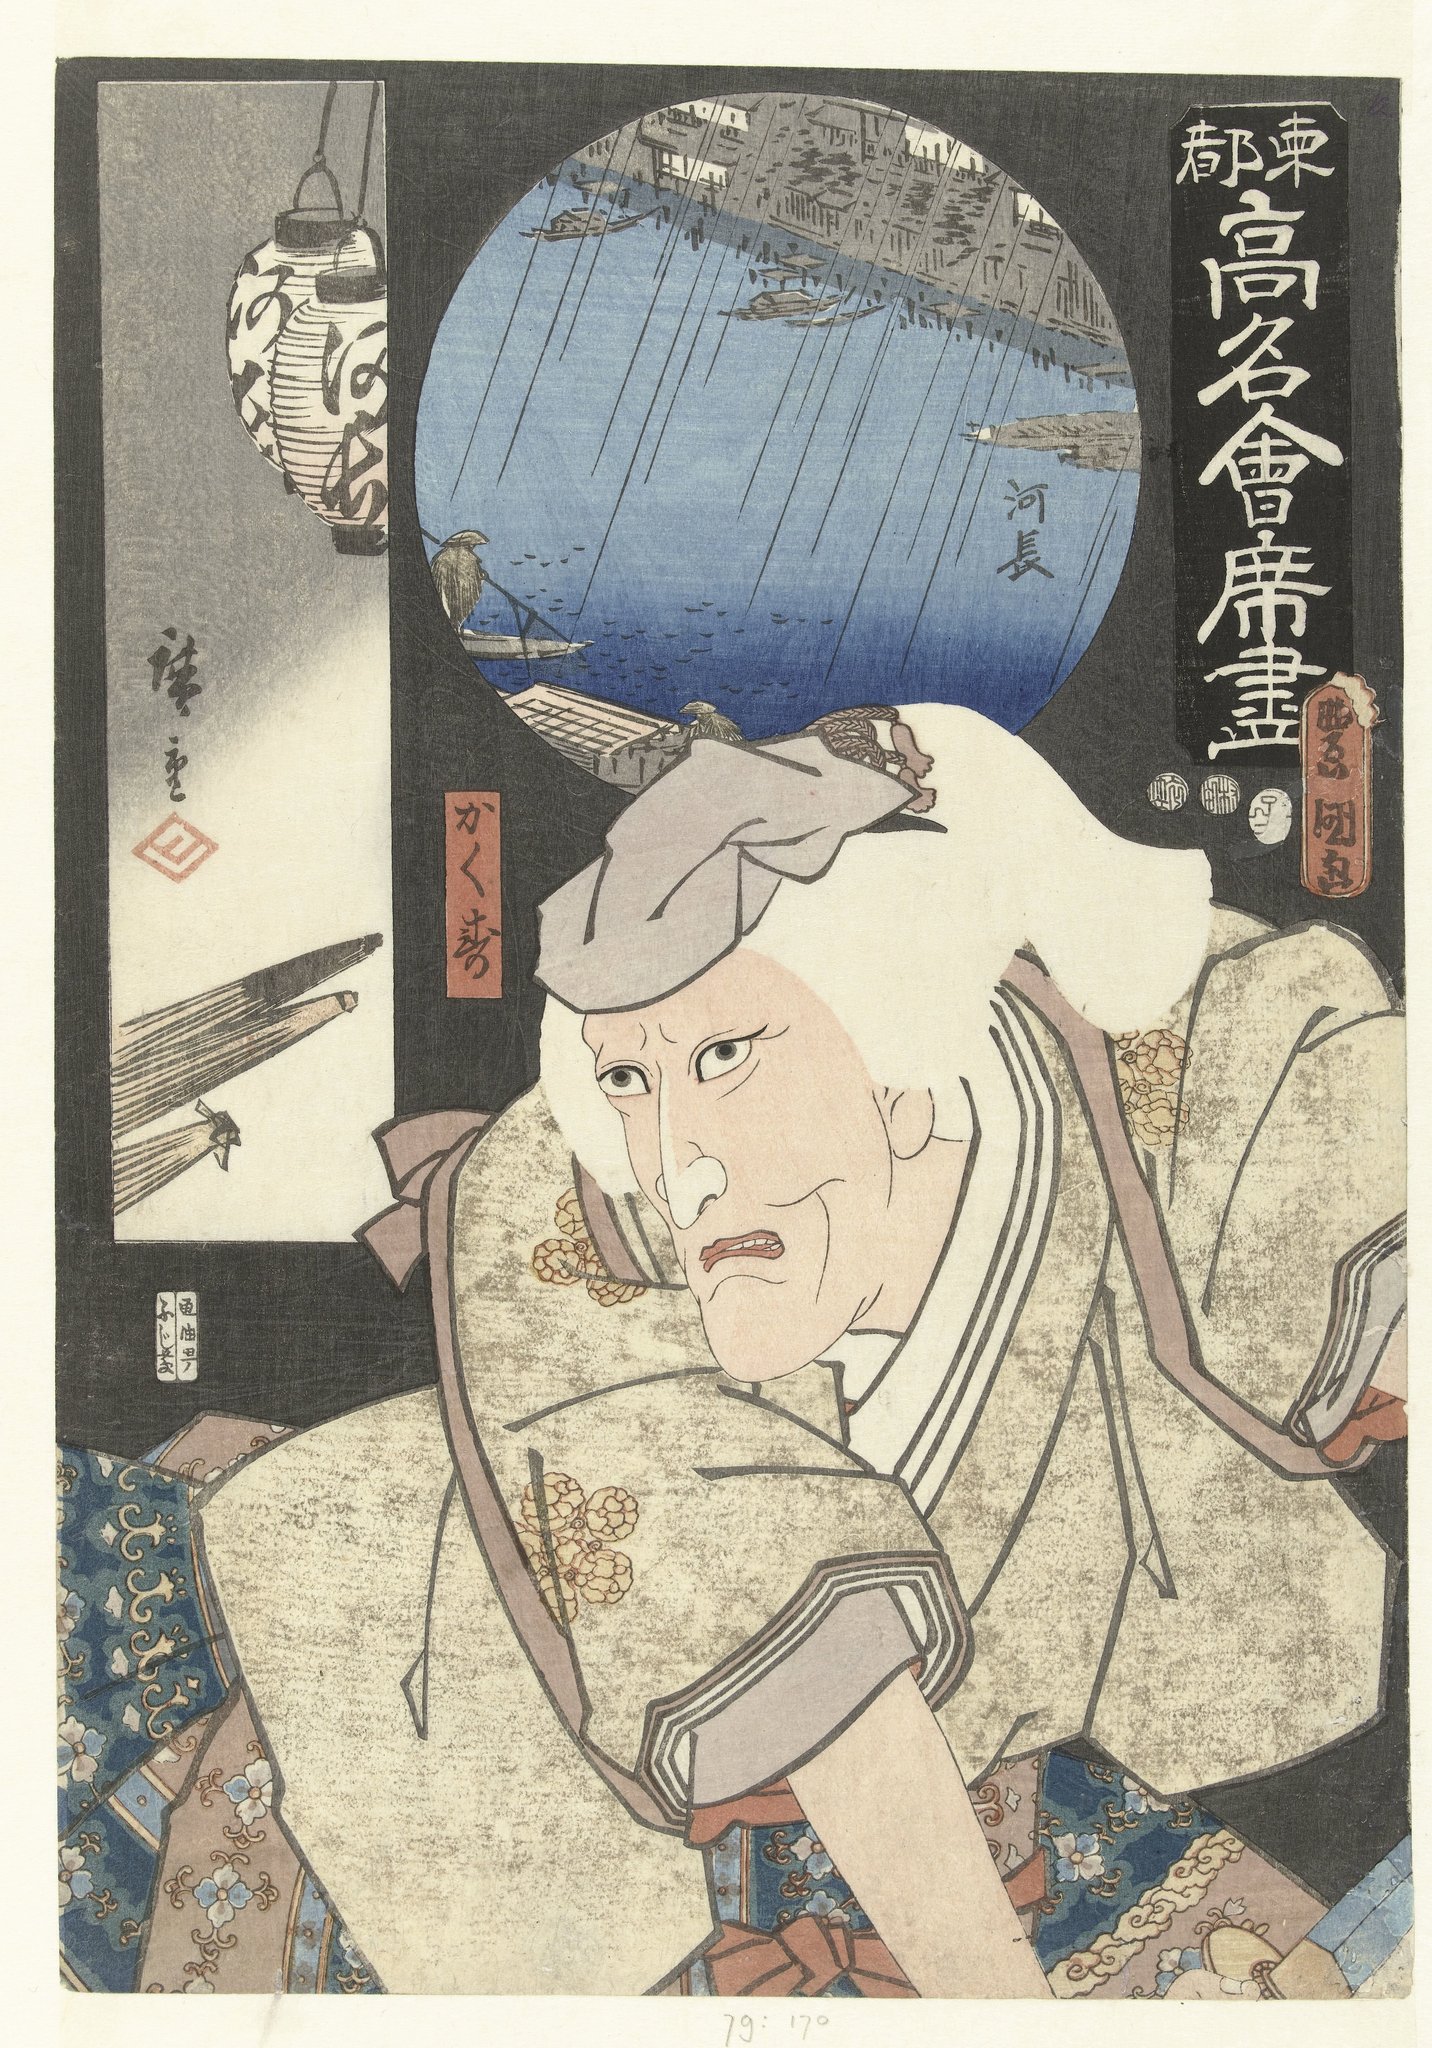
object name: print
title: Beroemde restaurants in de Oostelijke hoofdstad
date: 1852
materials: paper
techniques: woodcut, nishiki e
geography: japan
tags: female impersonation by actor, old woman, portrait of actor, actress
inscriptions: date